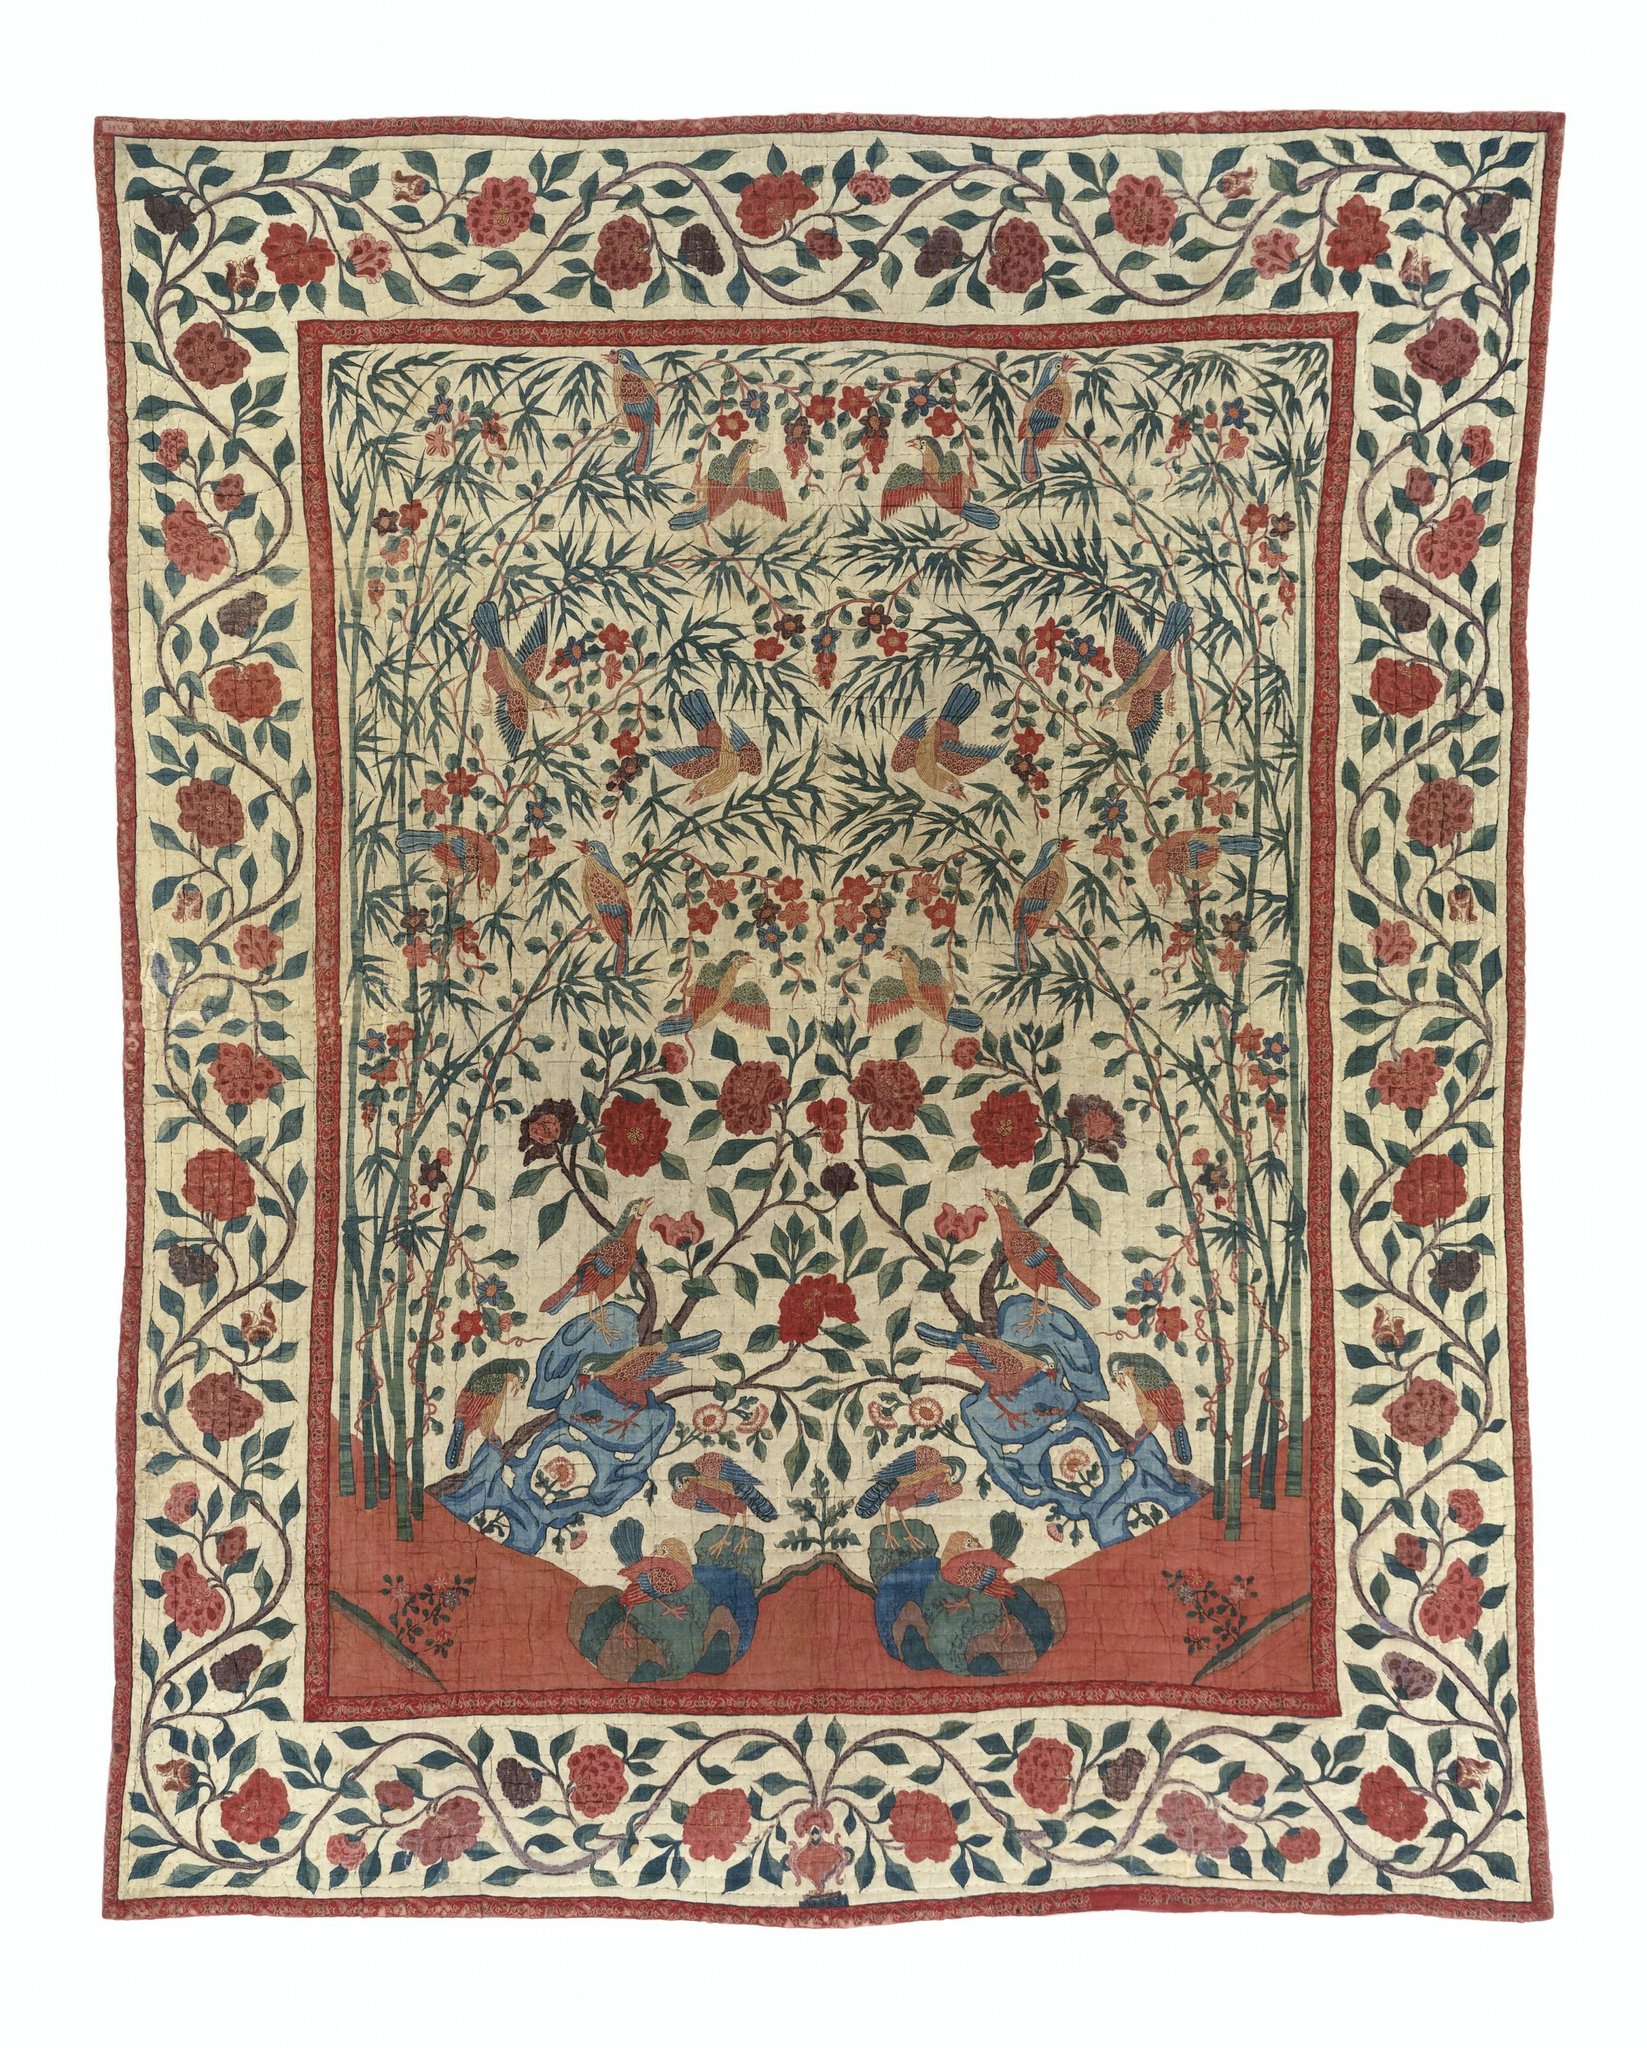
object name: textile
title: Sprei van sits, gewatteerd en doorgestikt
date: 1750-1775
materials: textile, cotton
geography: burhanpur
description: Sprei van sits, gewatteerd en doorgestikt en versierd met vogels op rotsen waaruit bloeiende planten groeien. Rand met golvende takken en bloemen. Gevoerd met rode katoen.